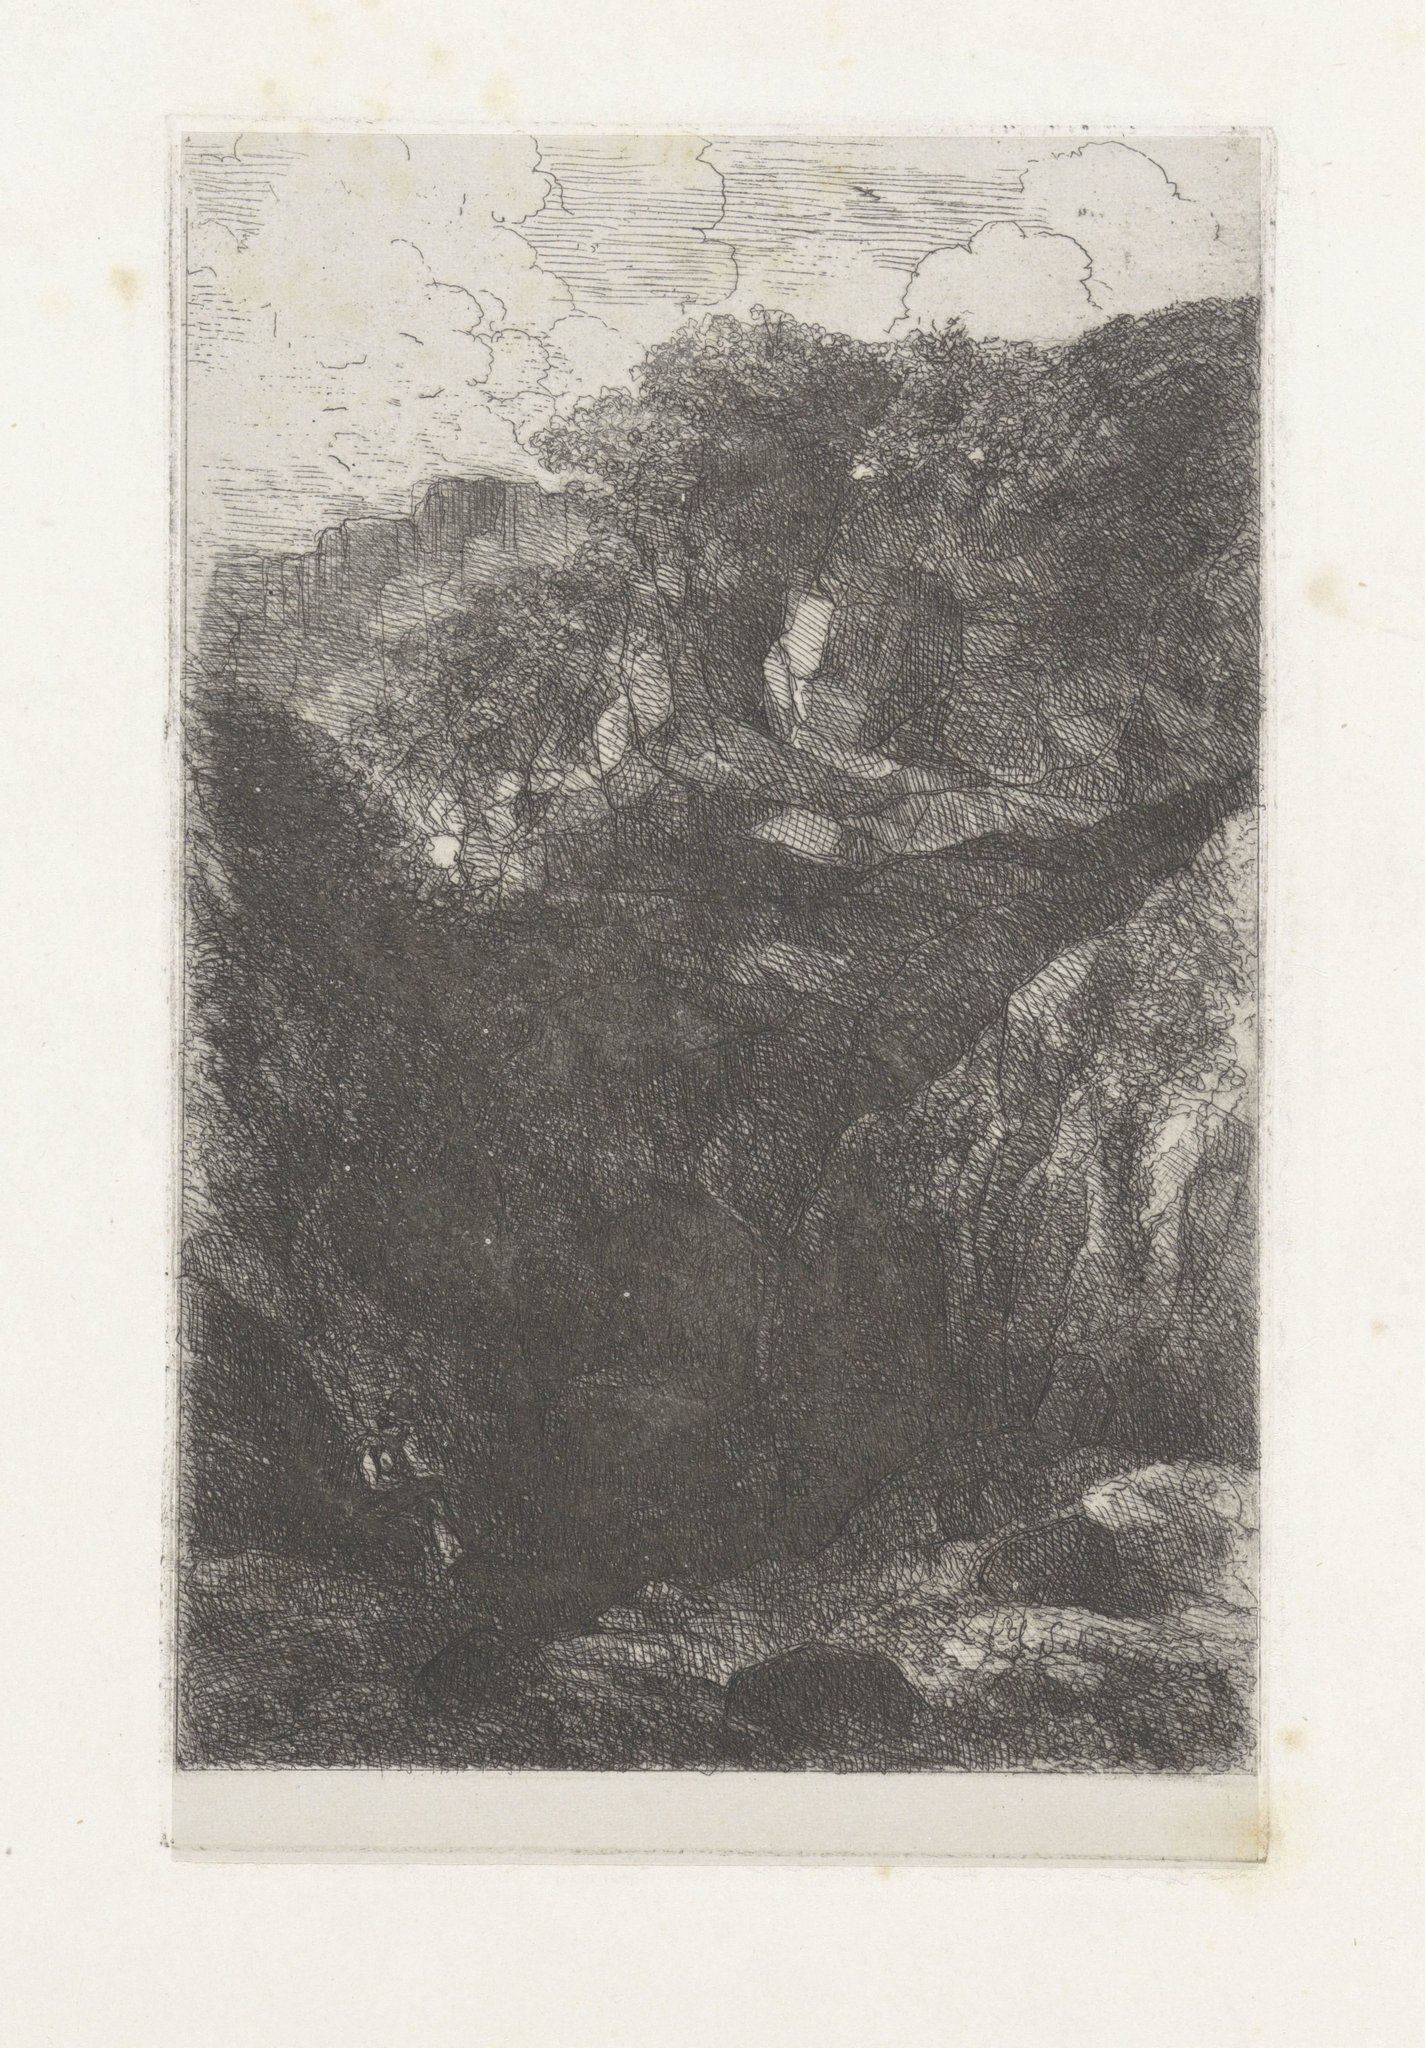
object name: print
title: Twee boven elkaar gelegen grotingangen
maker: alexander schaepkens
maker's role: draughtsman, print maker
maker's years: 1815-1899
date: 1859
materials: paper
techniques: etching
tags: cave, grotto, rock-formations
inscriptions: collector's mark: Lugt 2228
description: Ets uit de serie Montagne Saint Pierre, 11 planches, par Alexandre Schaepkens (1859).